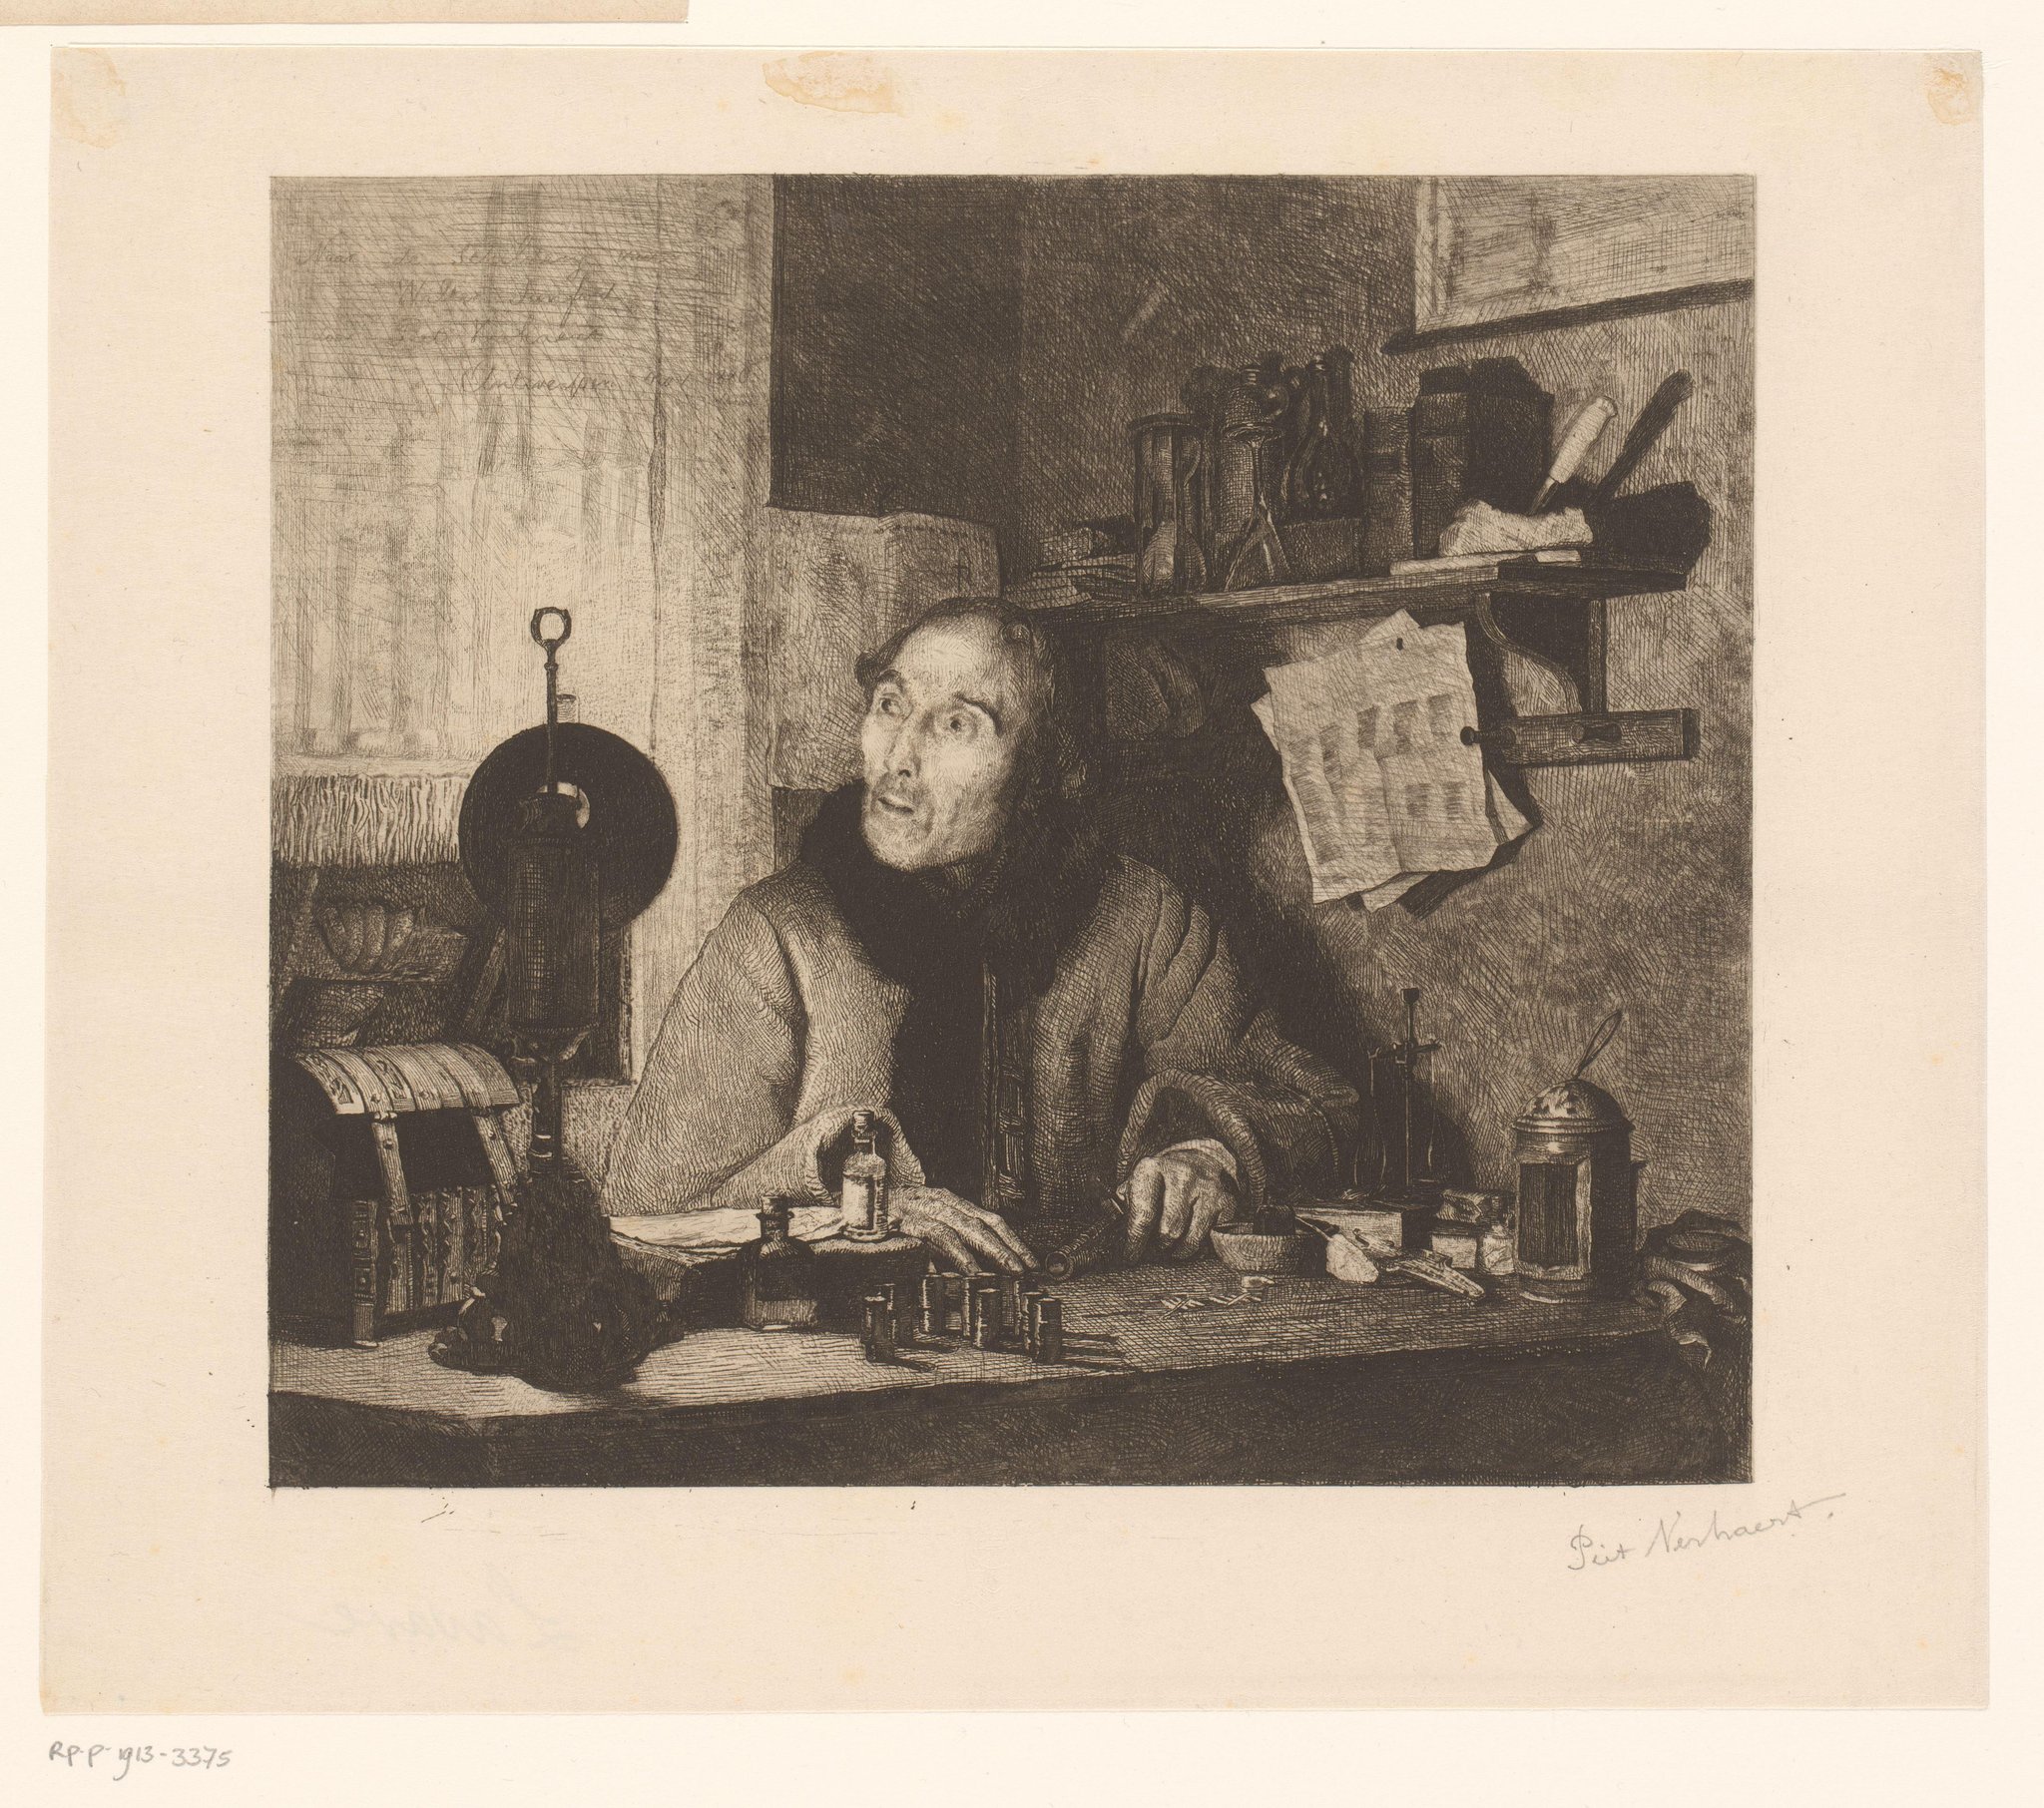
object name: print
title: Man weegt kostbaarheden bij lamplicht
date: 1886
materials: paper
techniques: etching, intaglio, retroussage, roulette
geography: antwerp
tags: adult man, scales, interior of the house, lighting; lamps, minerals and metals: gold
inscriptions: mark: ‘Antwerpsche Etsers 1880’, collector's mark: Lugt 2228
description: Links is een hand te zien van iemand die via een ladder naar het raam klimt.